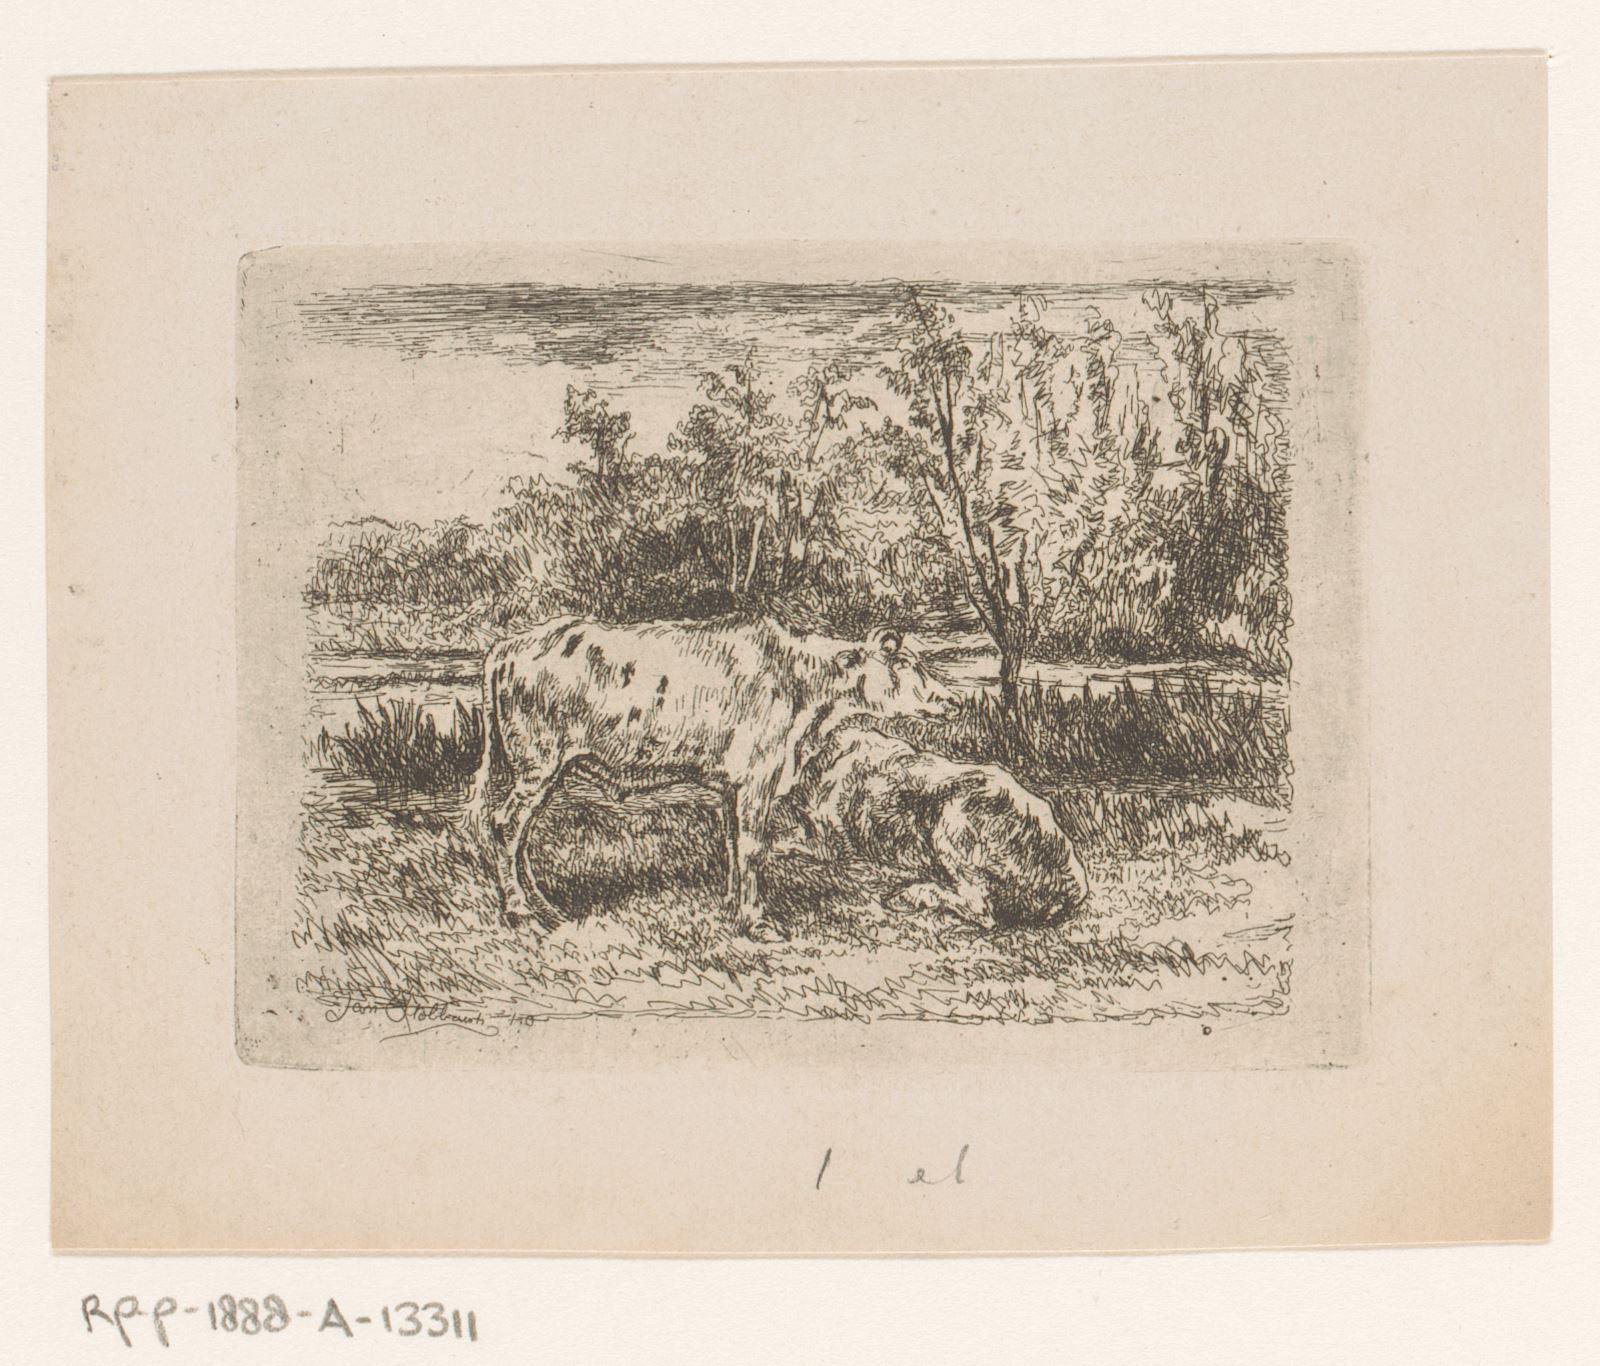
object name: print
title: Twee koeien in een weide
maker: jan stobbaerts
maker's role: draughtsman, print maker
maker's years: 1838-1914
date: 1848-1879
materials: paper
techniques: etching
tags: cow, meadow, pasture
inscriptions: collector's mark: Lugt 2228